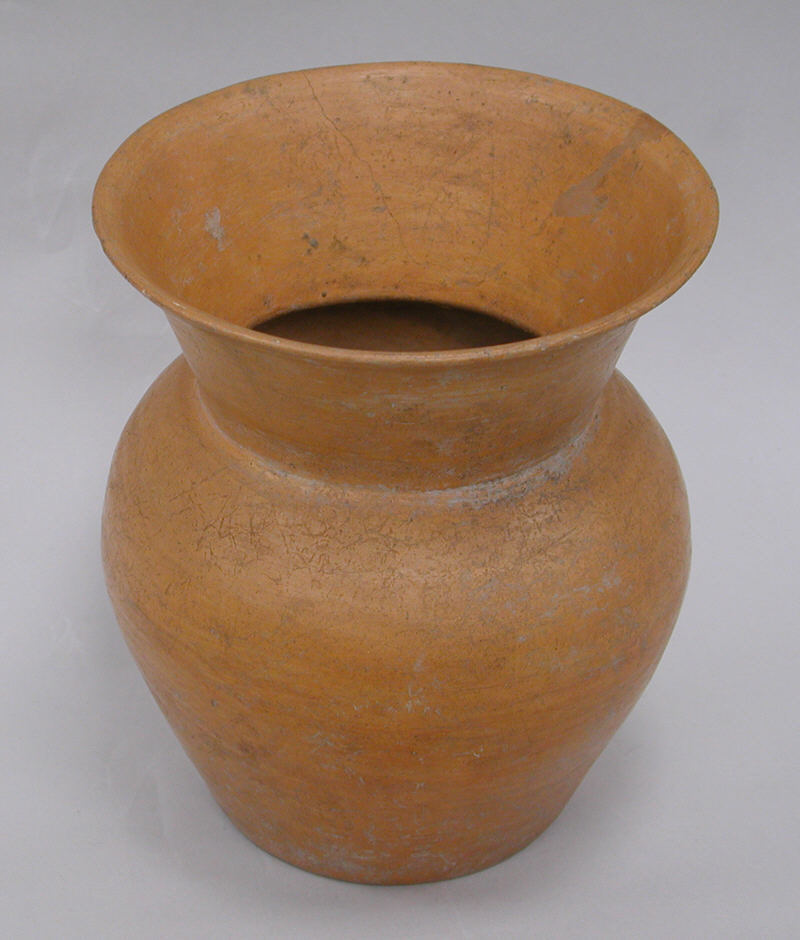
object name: jar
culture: teotihuacan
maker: teotihuacan artist(s)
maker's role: artist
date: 350-550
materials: ceramic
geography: mexico